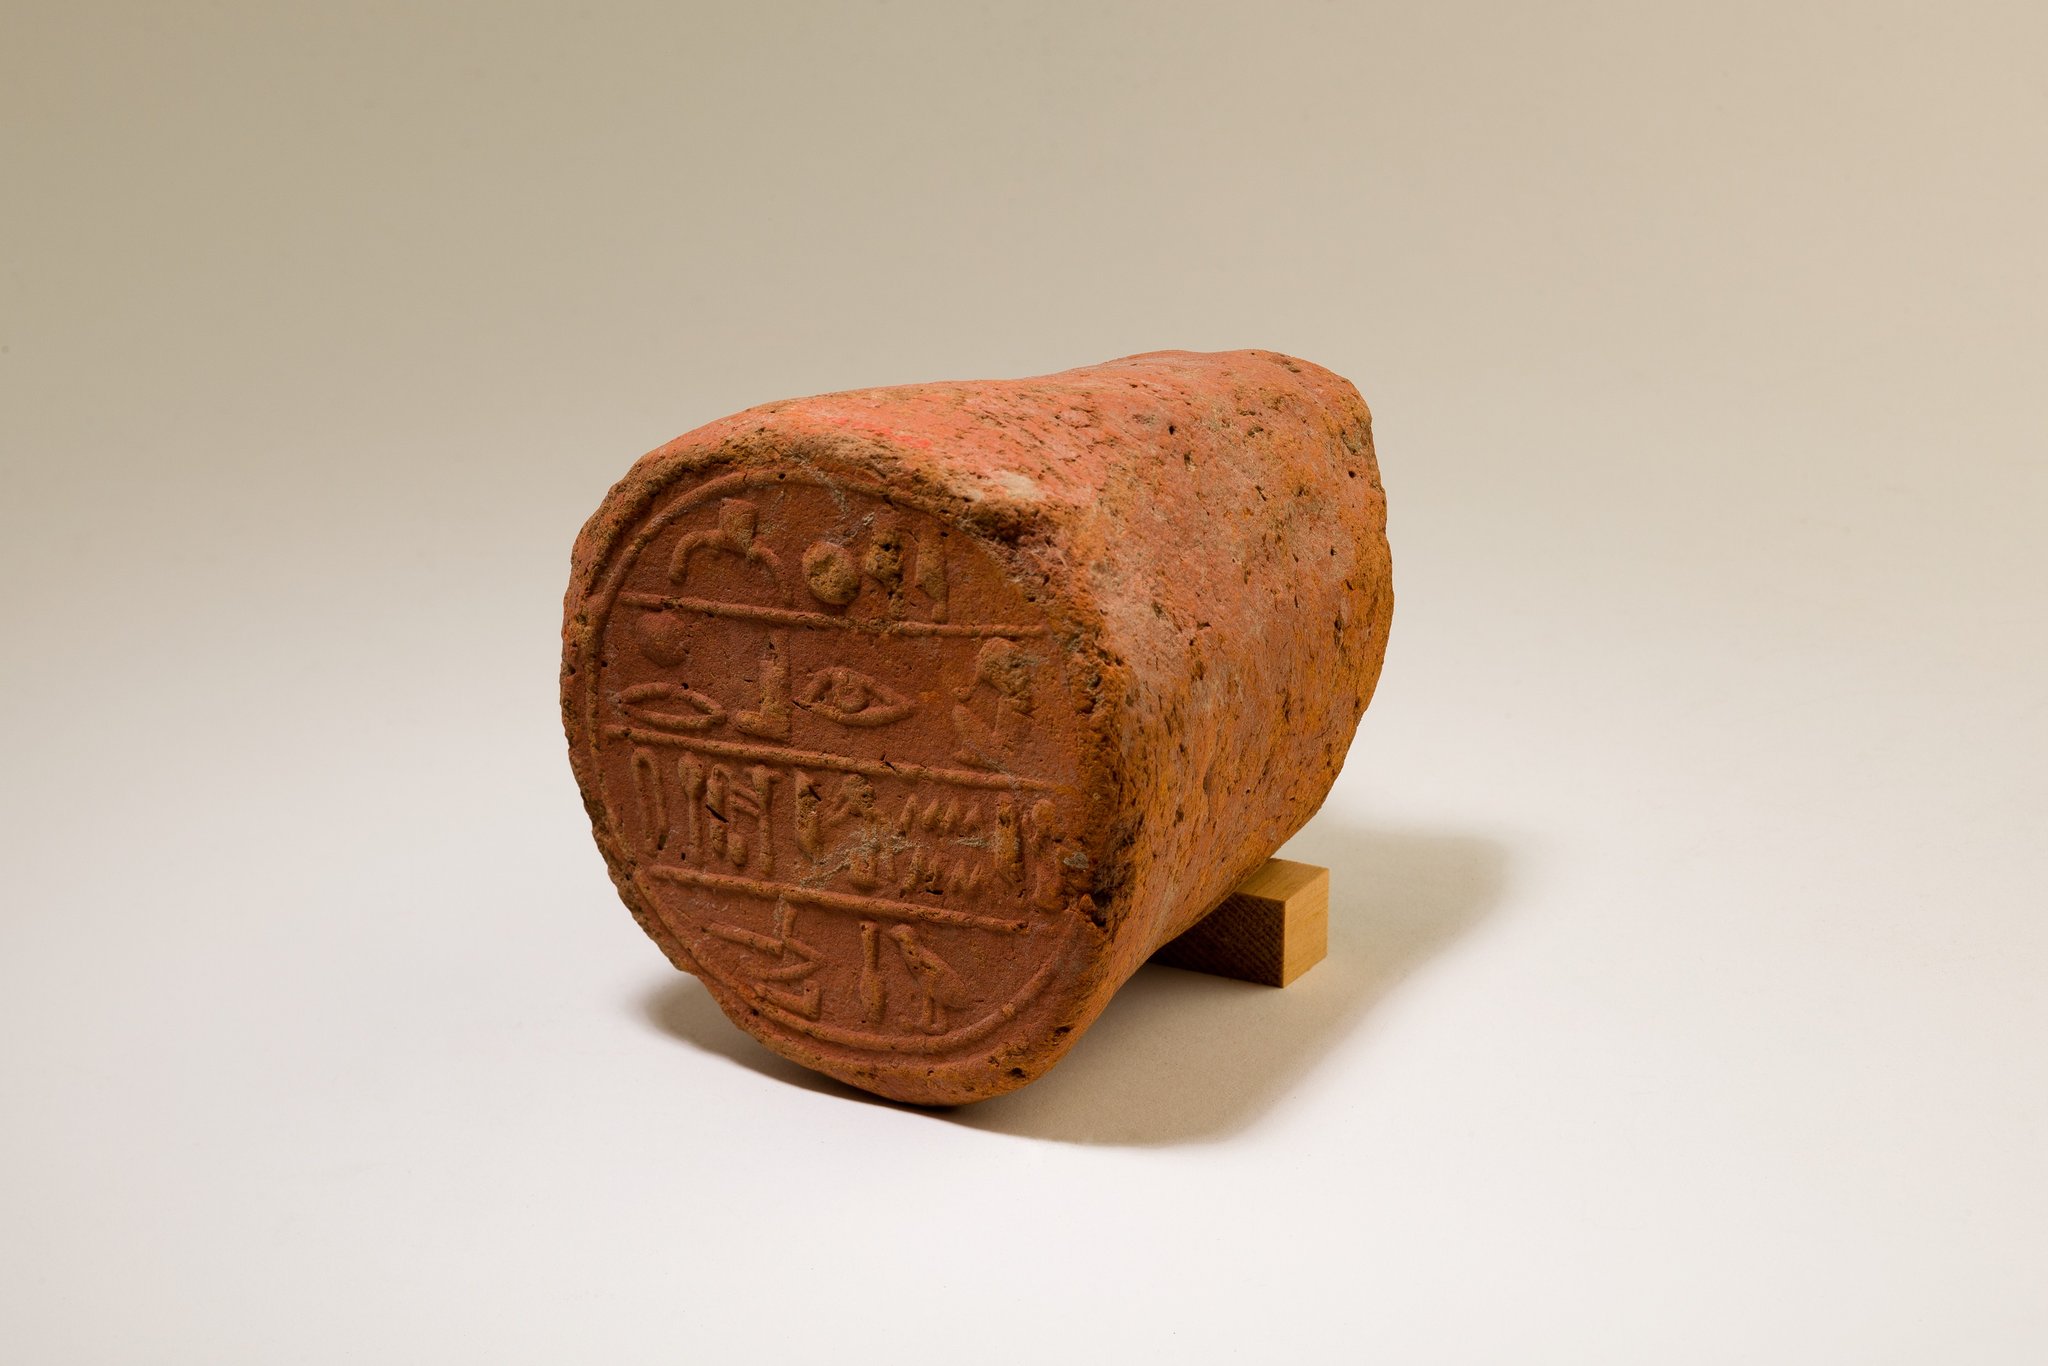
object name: cone, curcular impression, ineni, inspector of scribe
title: Funerary Cone of the Overseer of Scribes Ineni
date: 1550-1295 BCE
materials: pottery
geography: egypt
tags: hieroglyphs